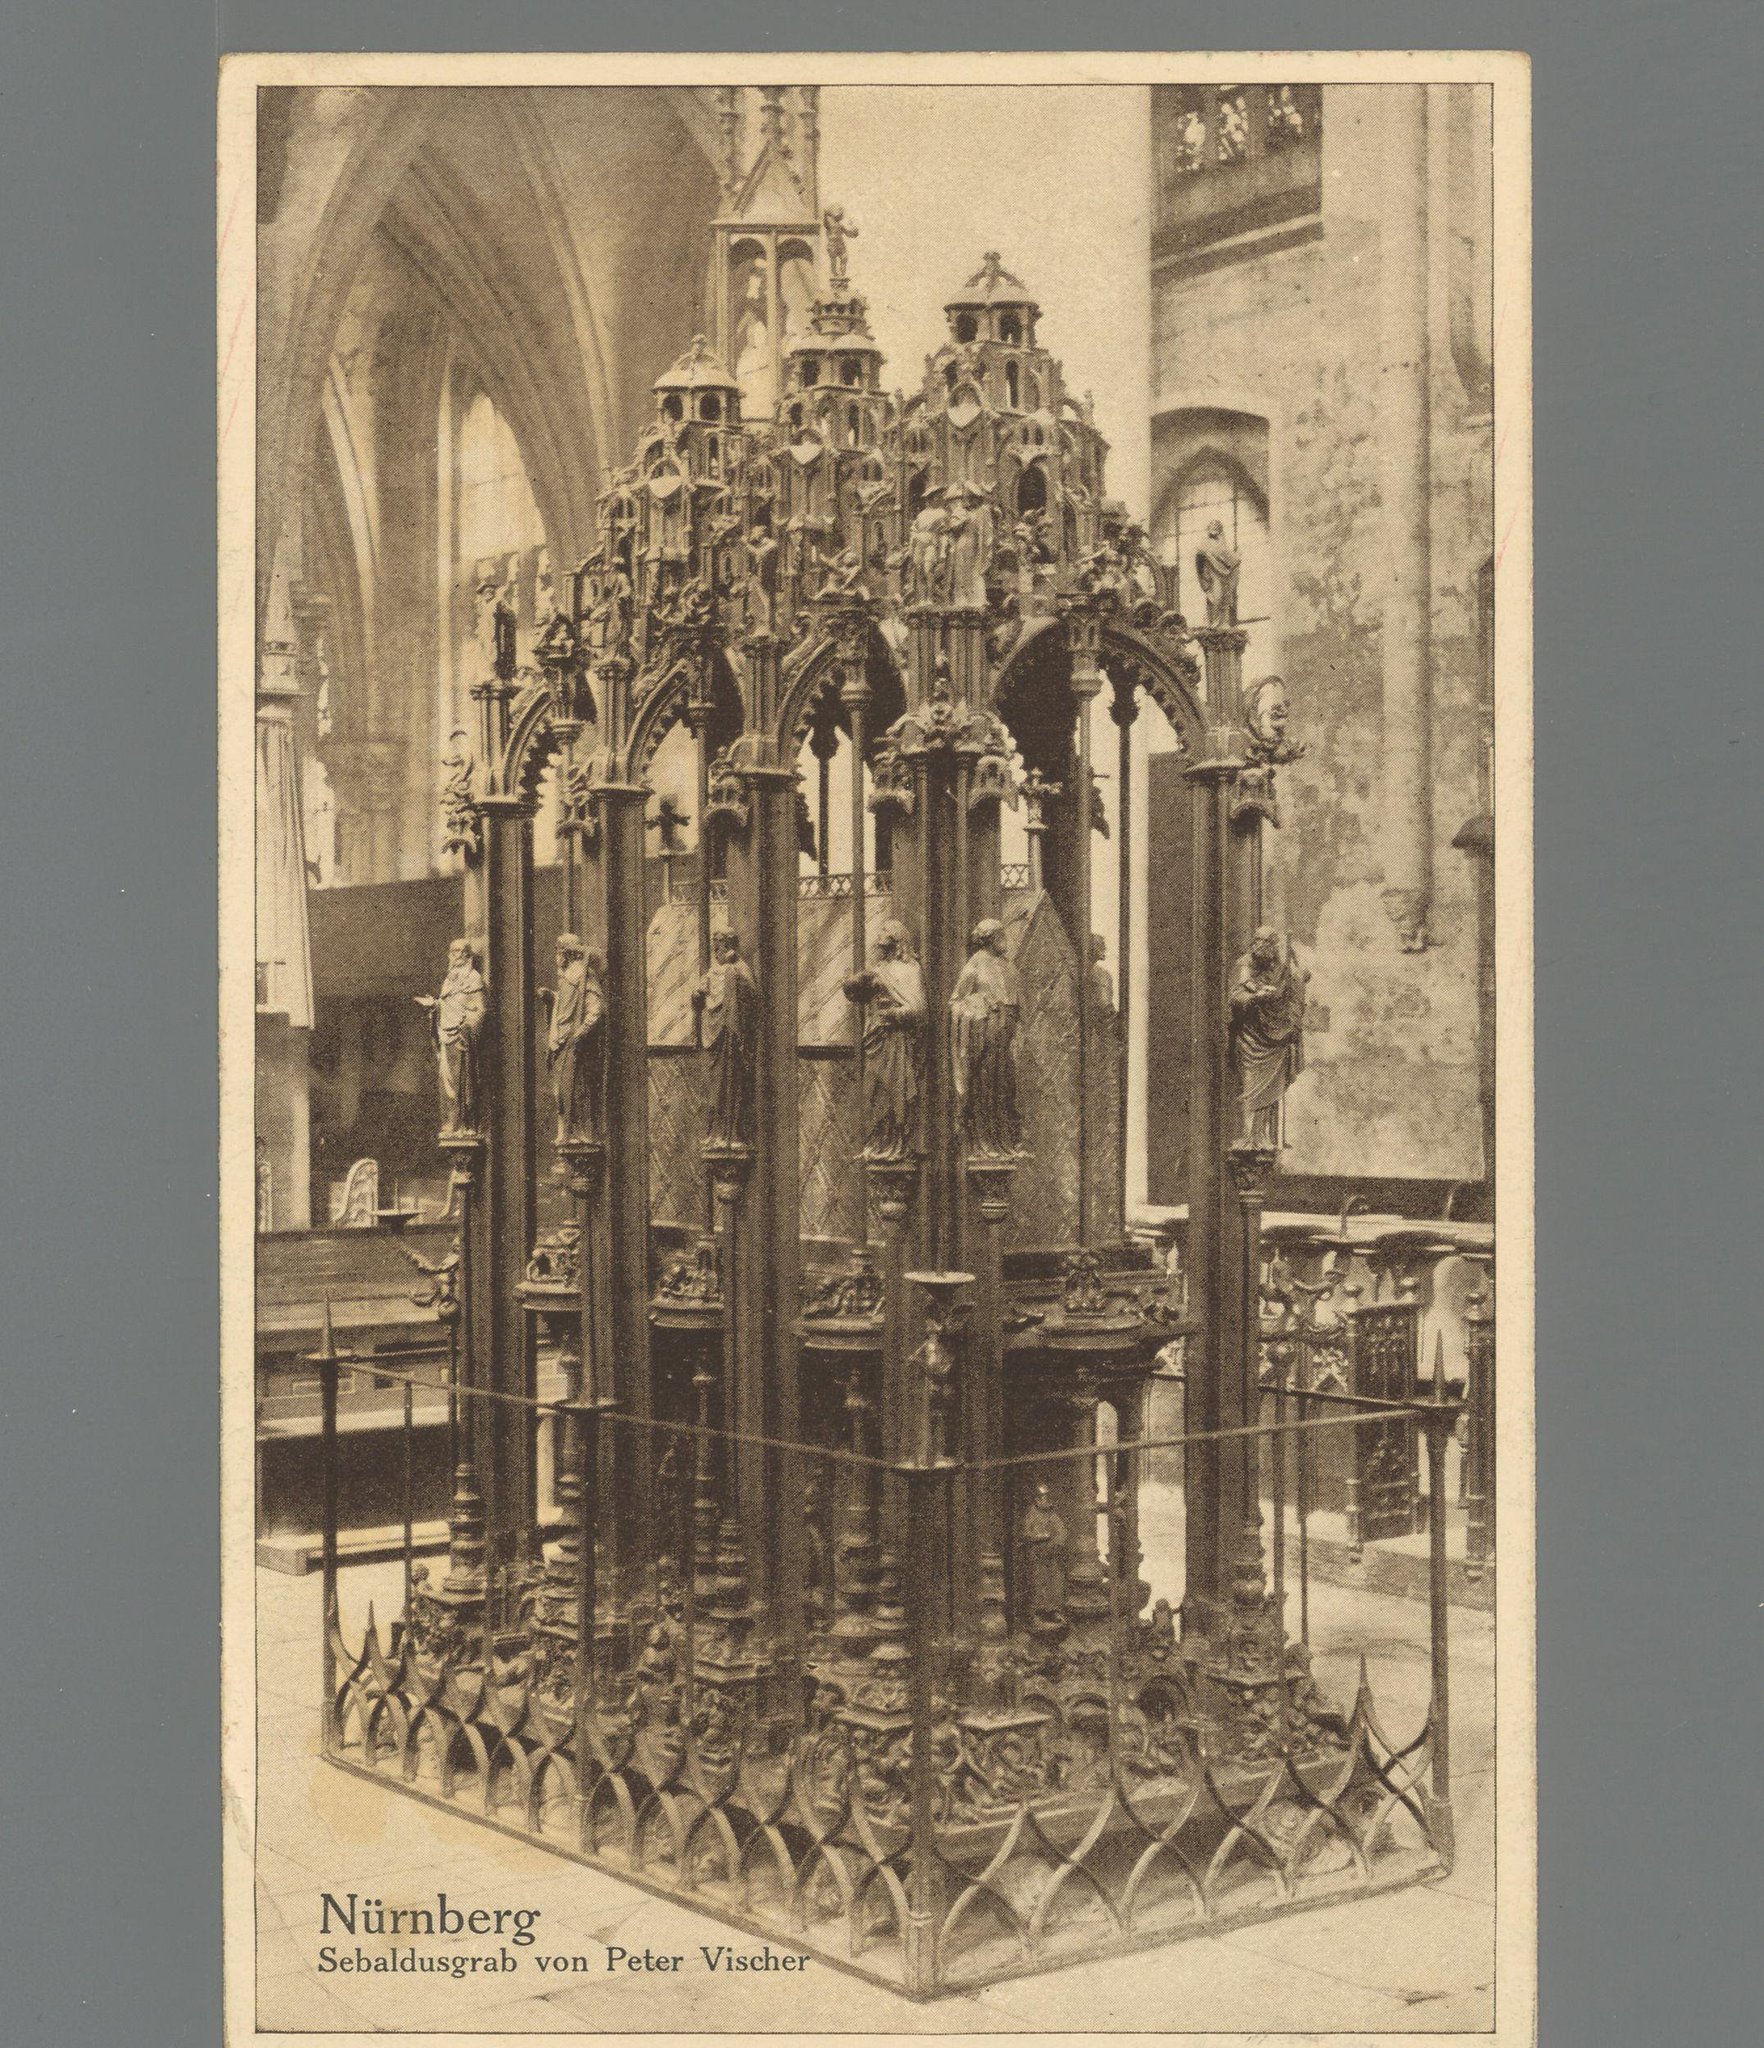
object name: ansichtkaart, prentbriefkaart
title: Nürnberg. Sebaldusgrab von Peter Vischer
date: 1905-1912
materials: cardboard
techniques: writing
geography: nuremberg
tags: grave, tomb, interior of church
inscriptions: postage stamp